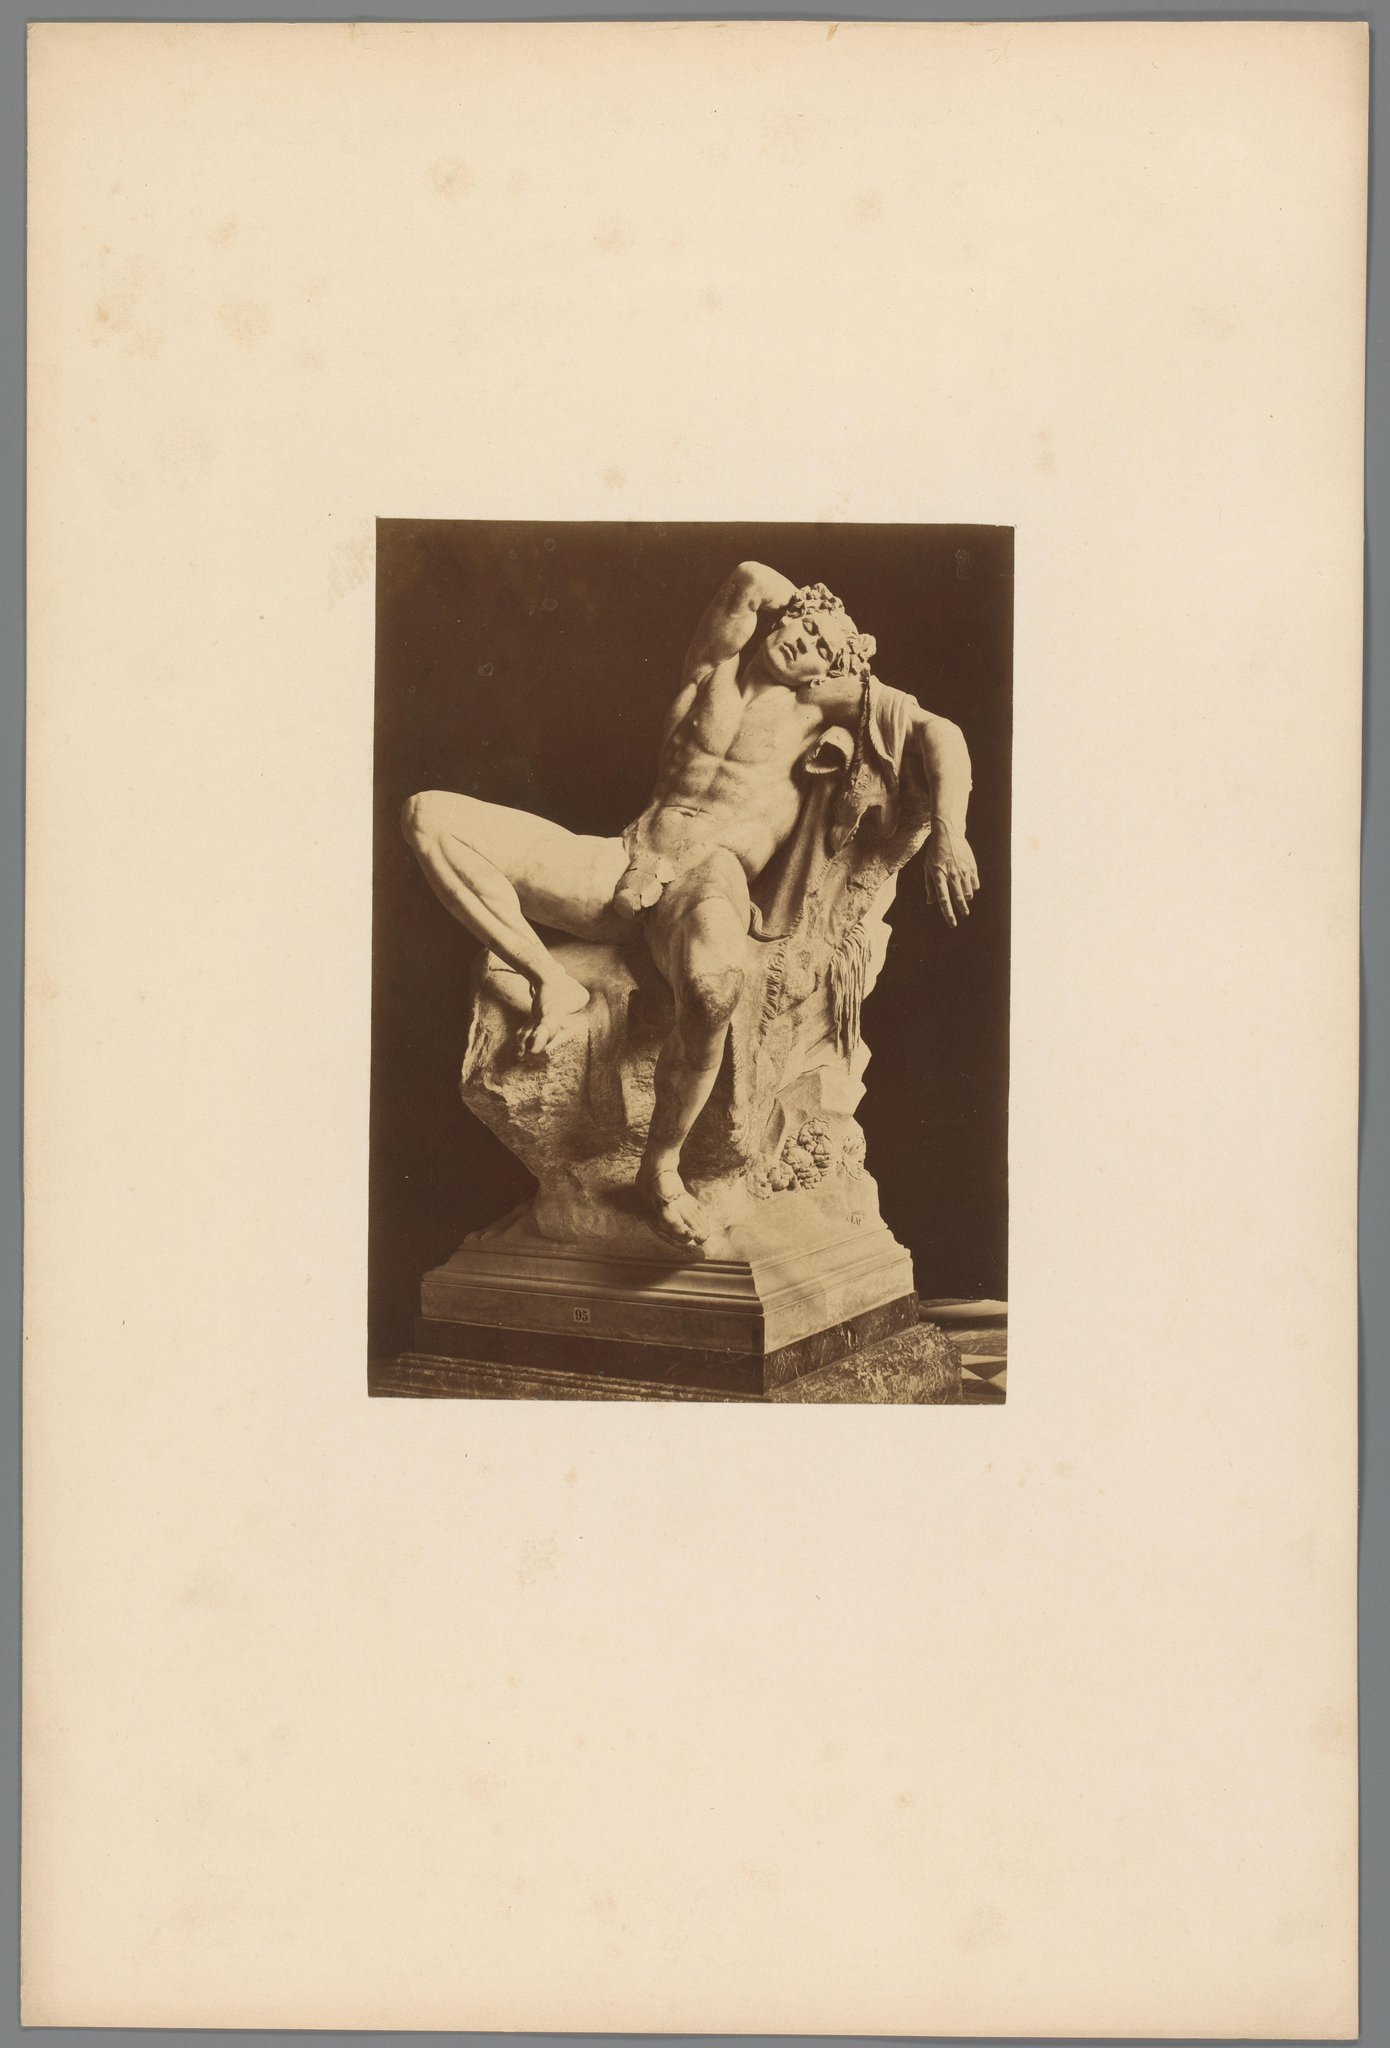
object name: photograph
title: Sculptuur van een slapende faun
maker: Anonymous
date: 1851-1900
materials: cardboard, paper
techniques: albumen print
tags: piece of sculpture, reproduction of a piece of sculpture